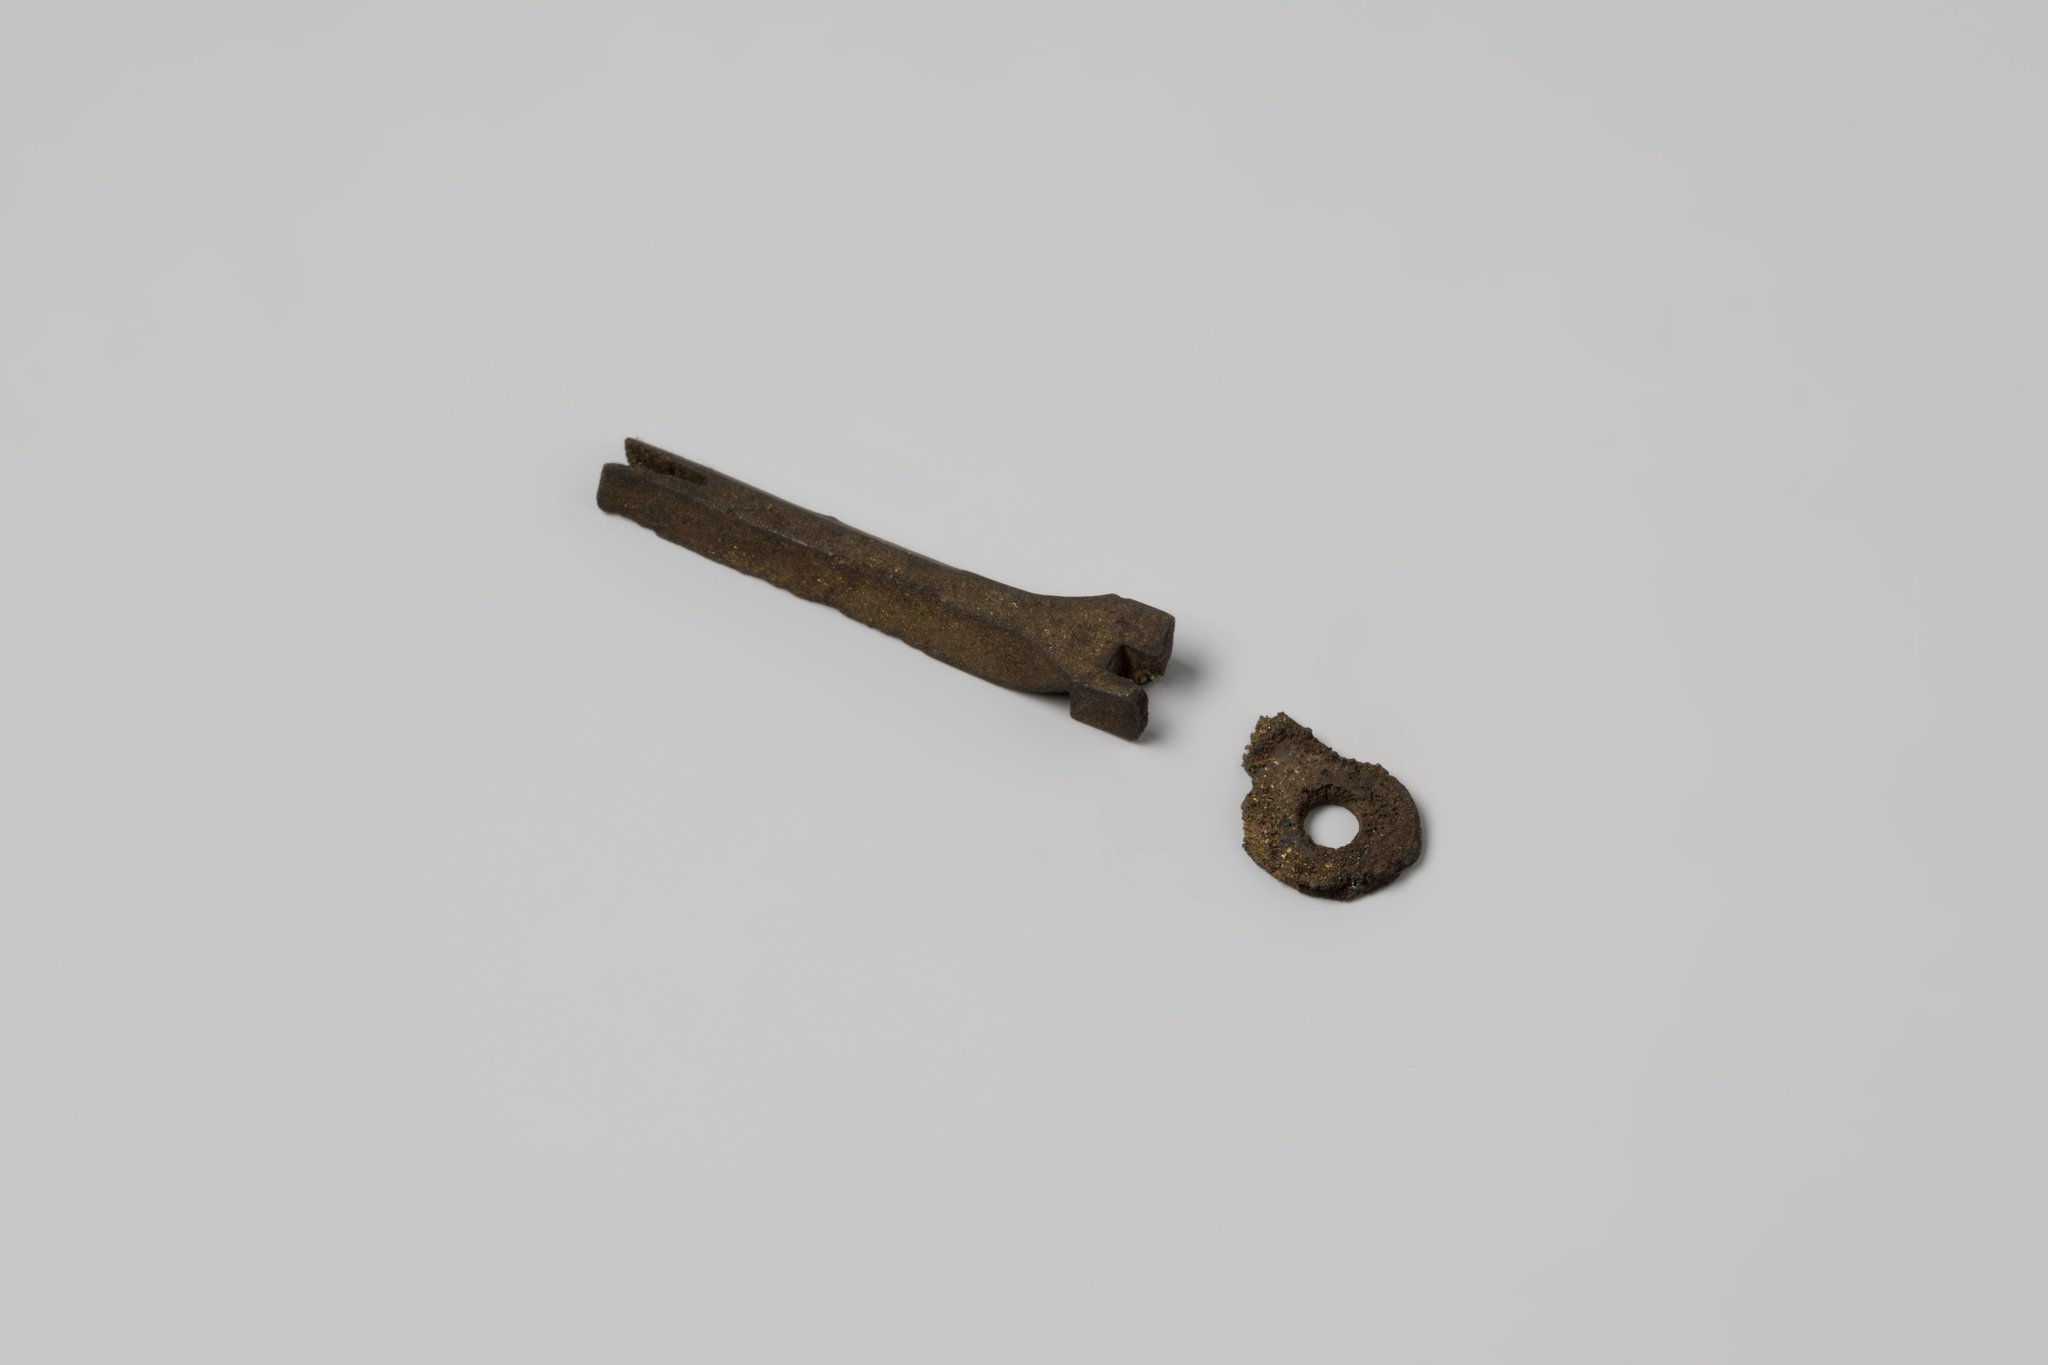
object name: divider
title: Fragment steekpasser uit het wrak van de Oost-Indiëvaarder Hollandia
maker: Anonymous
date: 1700-1743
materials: copper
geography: netherlands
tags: verenigde oostindische compagnie, hollandia (schip), annet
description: Divider; fragment: leg id. NG 1980-27H1171: circular pivot end.